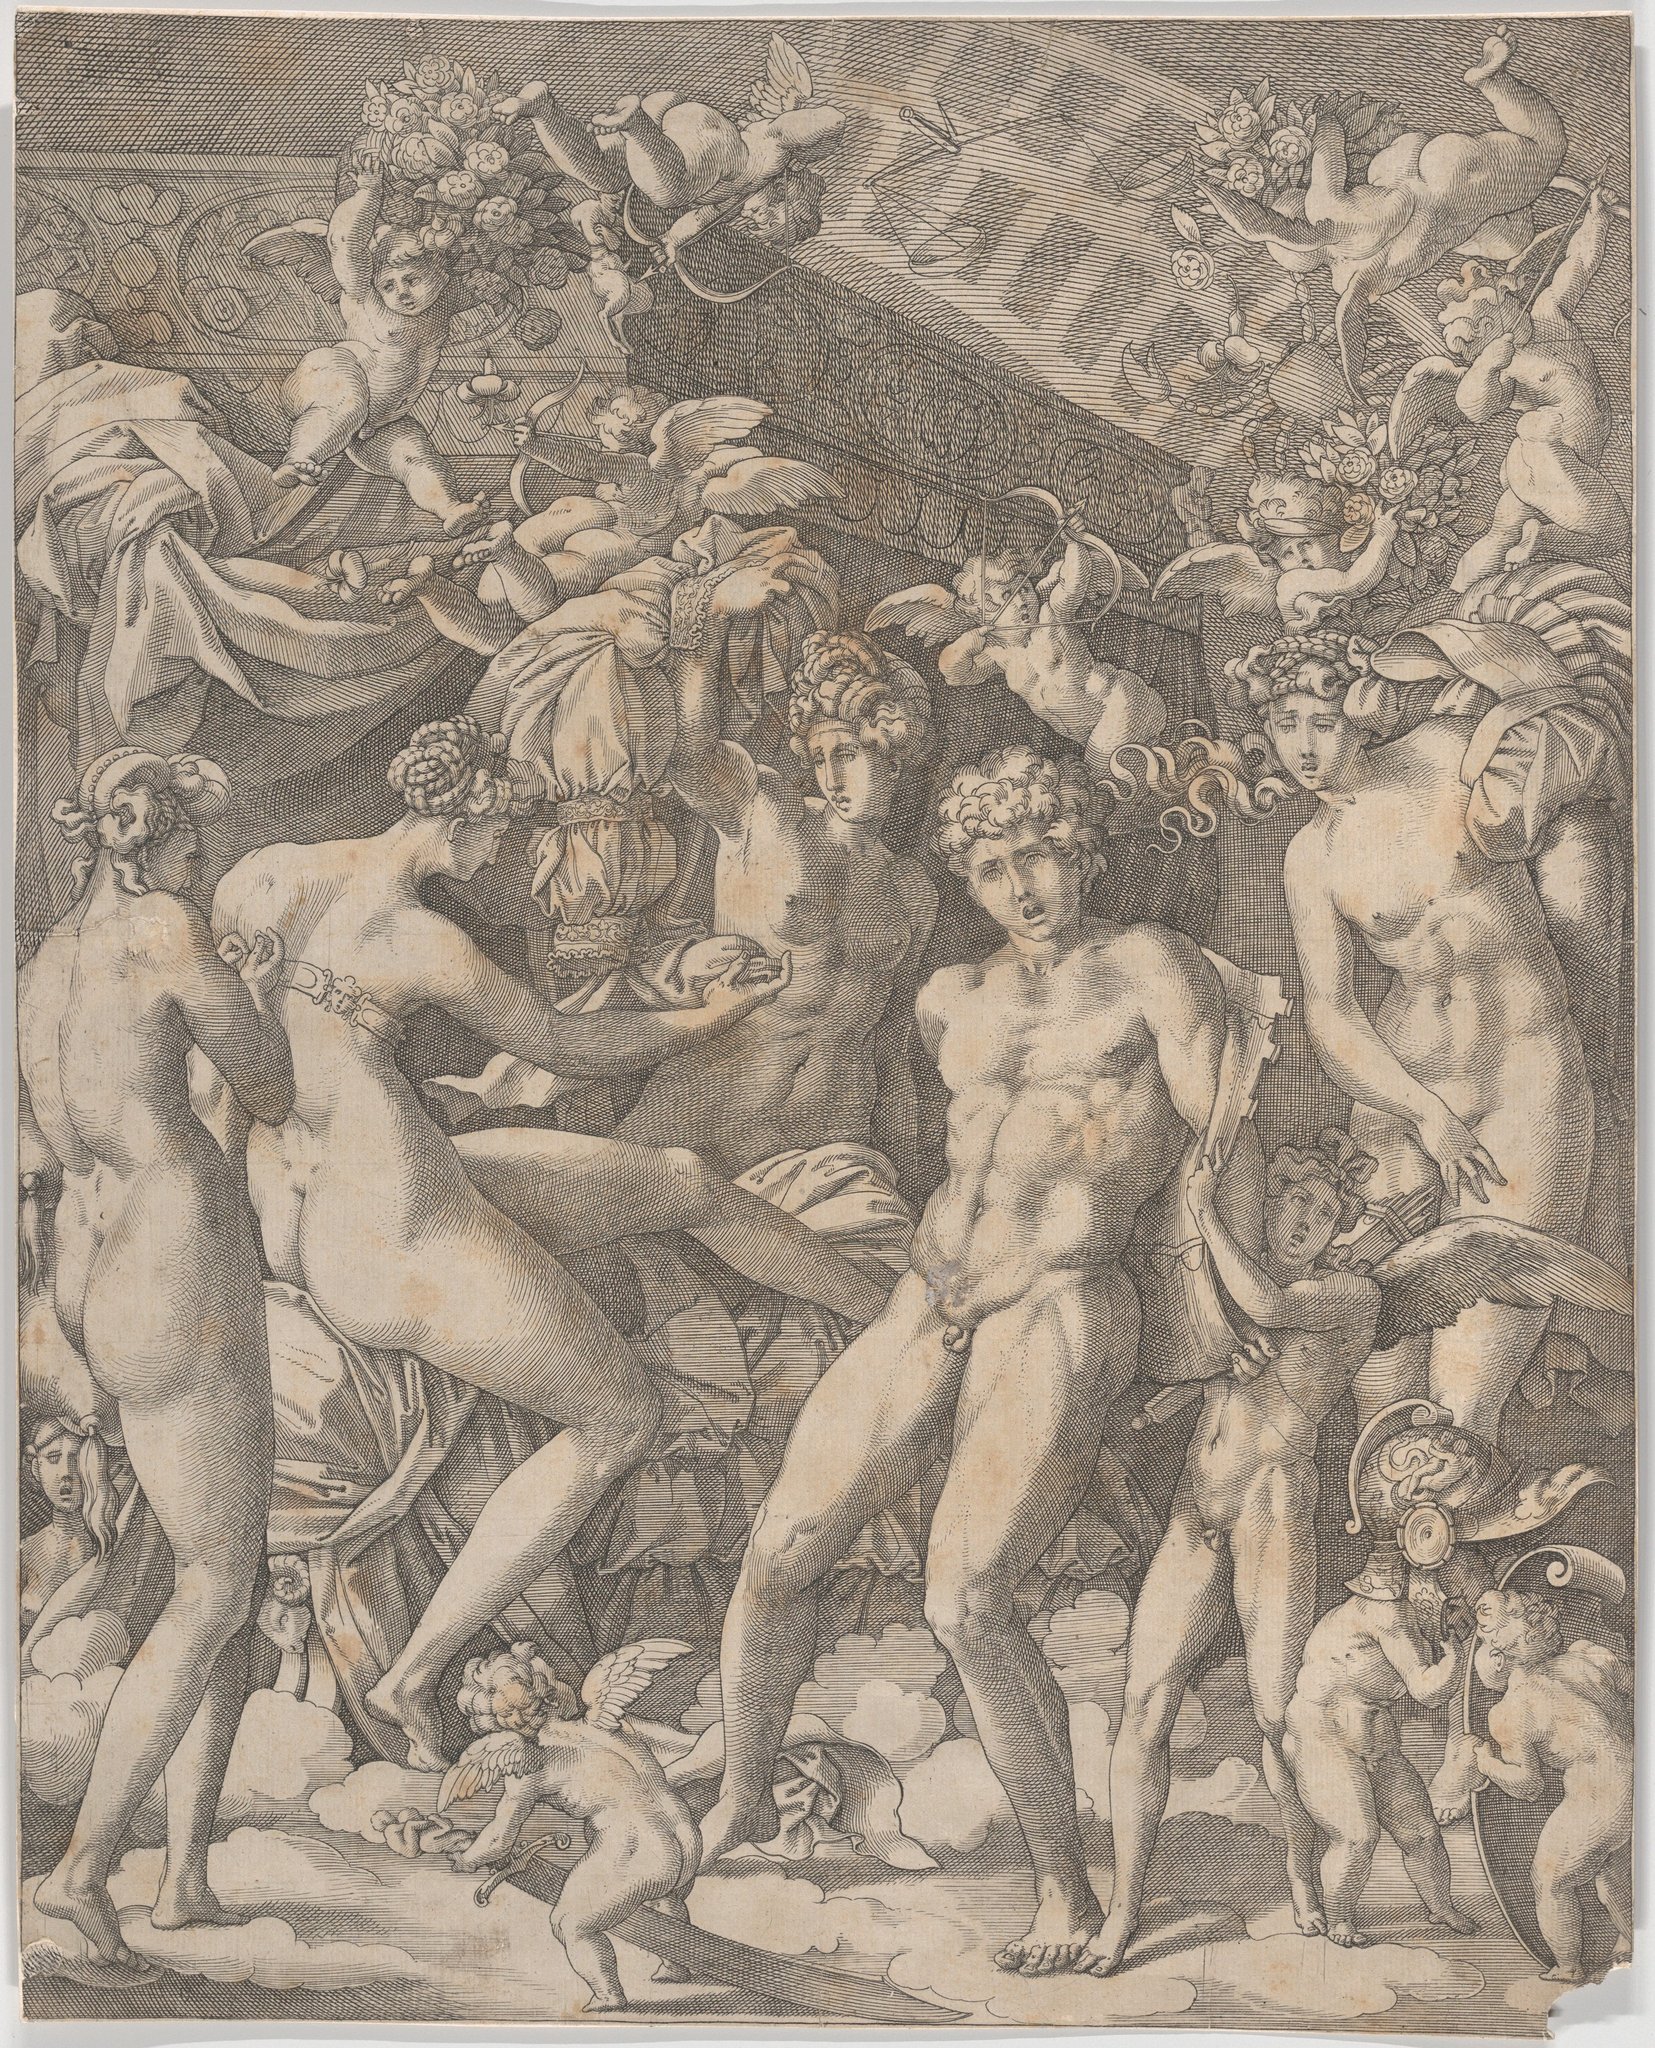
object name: print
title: Venus and Mars with Cupid and the Three Graces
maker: master hcb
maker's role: artist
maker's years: 1565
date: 1530-1535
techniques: engraving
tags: cupid,mars,venus,goddess